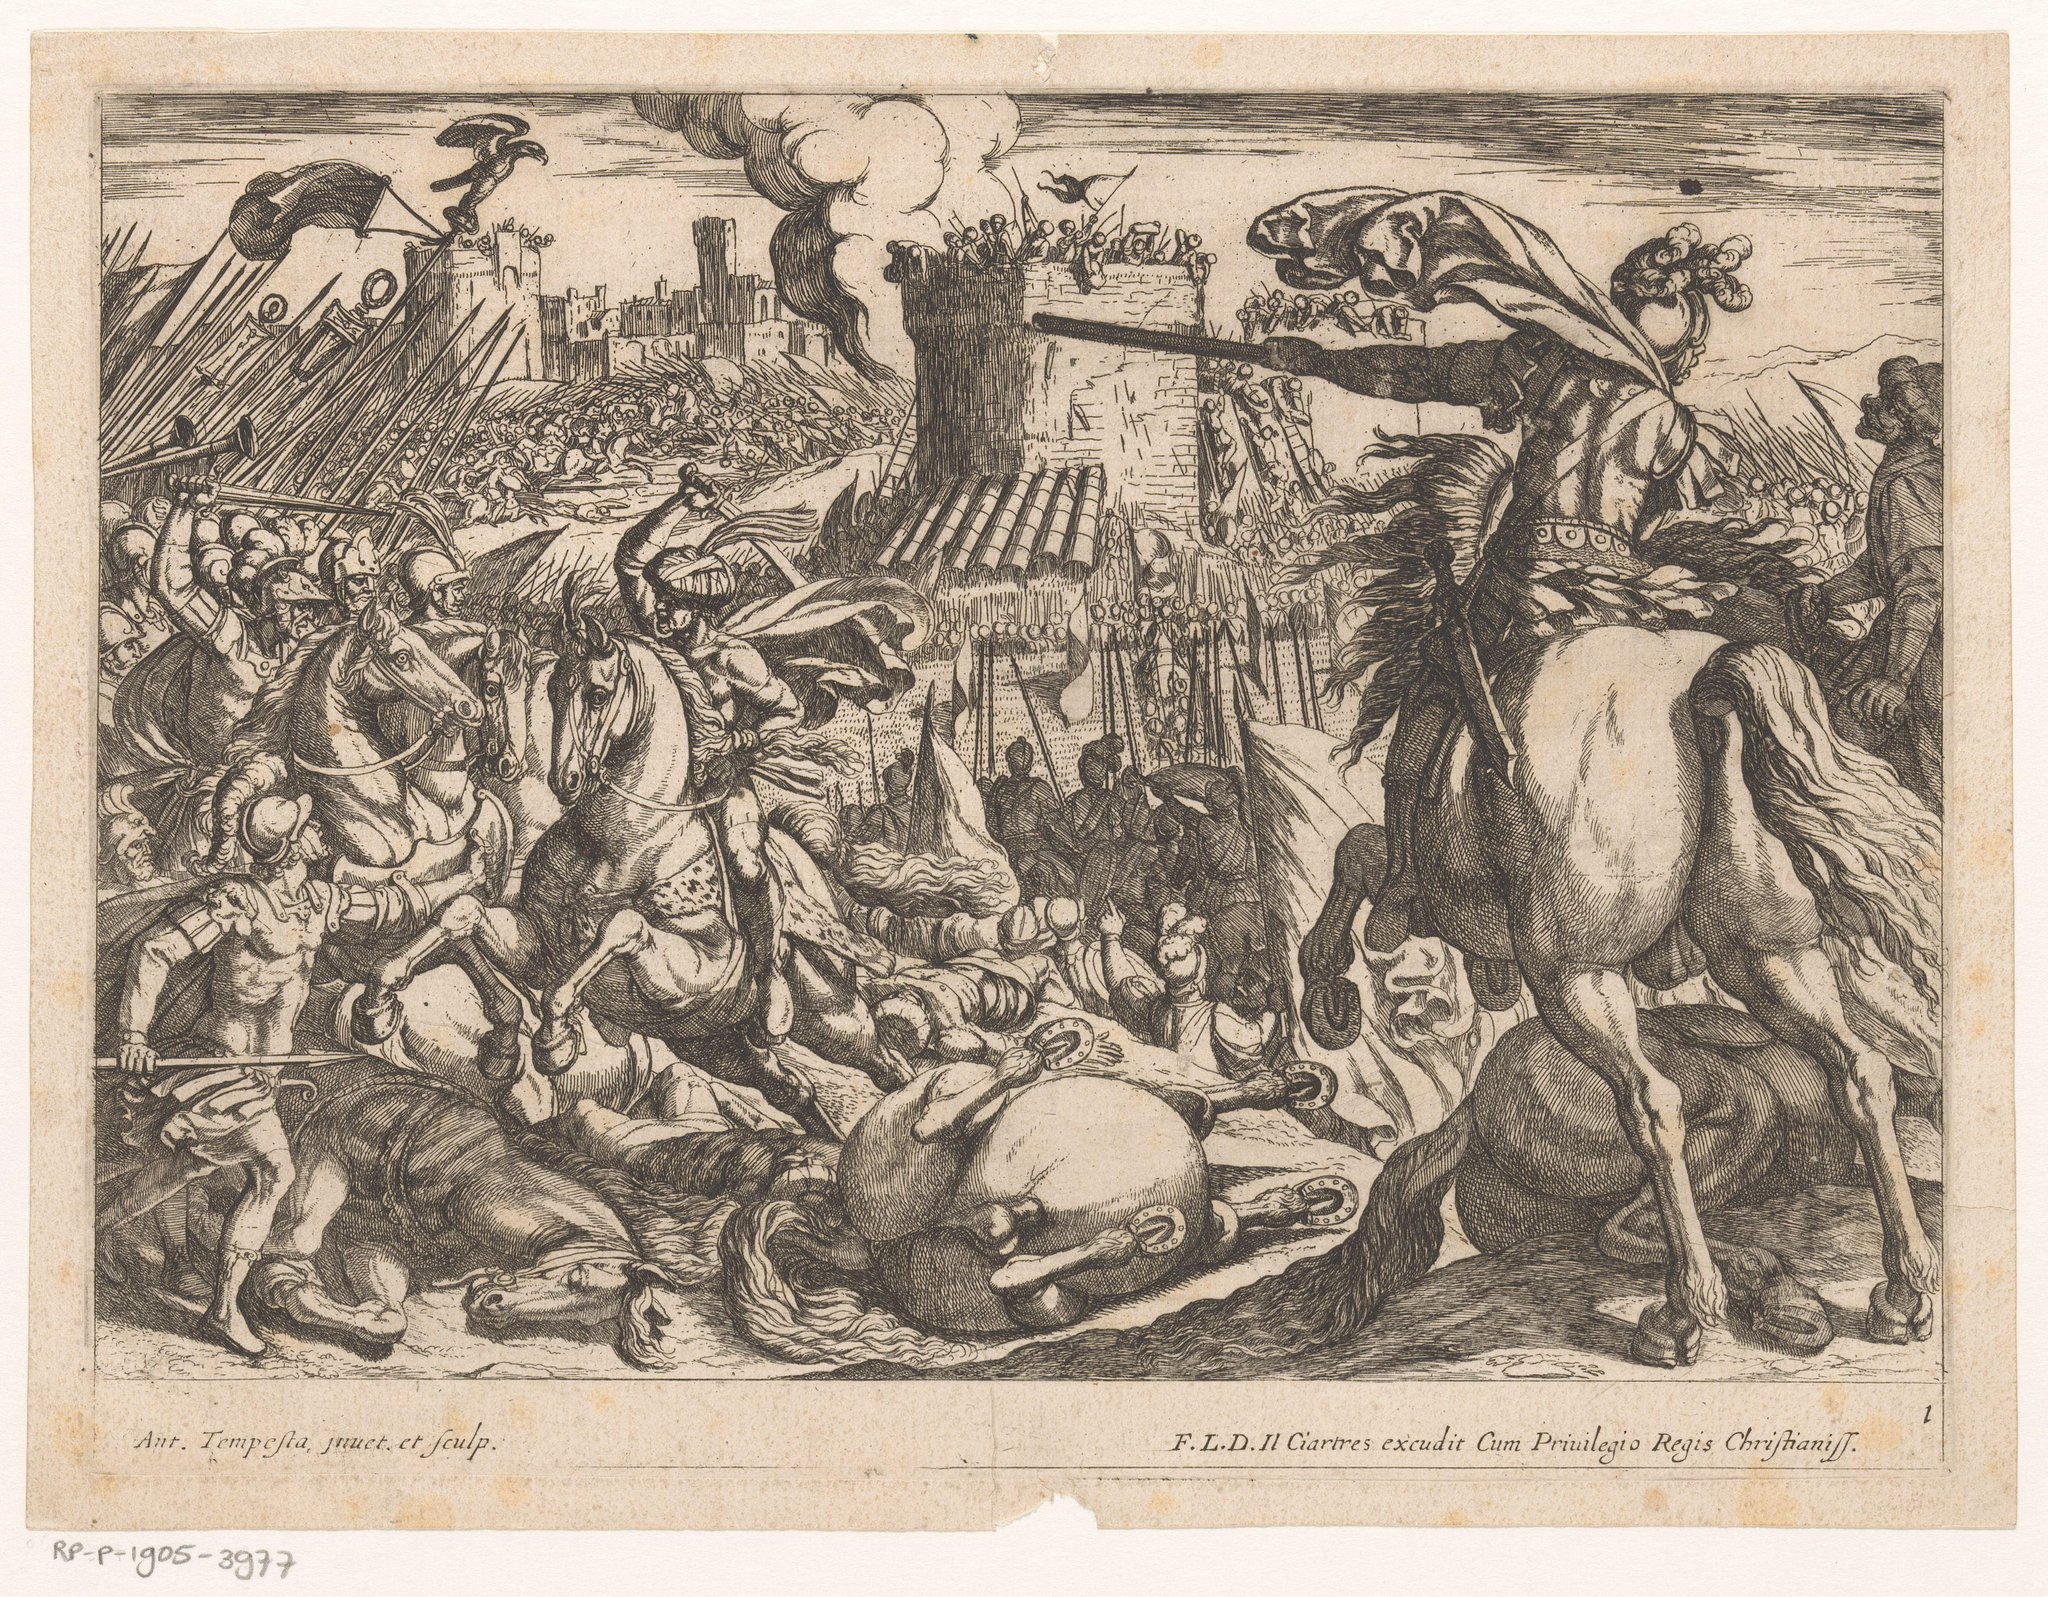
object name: print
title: Ruitergevecht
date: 1565-1630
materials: paper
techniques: etching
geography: italy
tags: battle, warfare; military affairs (+ cavalry, horsemen), the soldier; the soldier's life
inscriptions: collector's mark: Lugt 2228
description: Strijdende soldaten te paard voor een stad. Genummerd rechtsonder: 1.